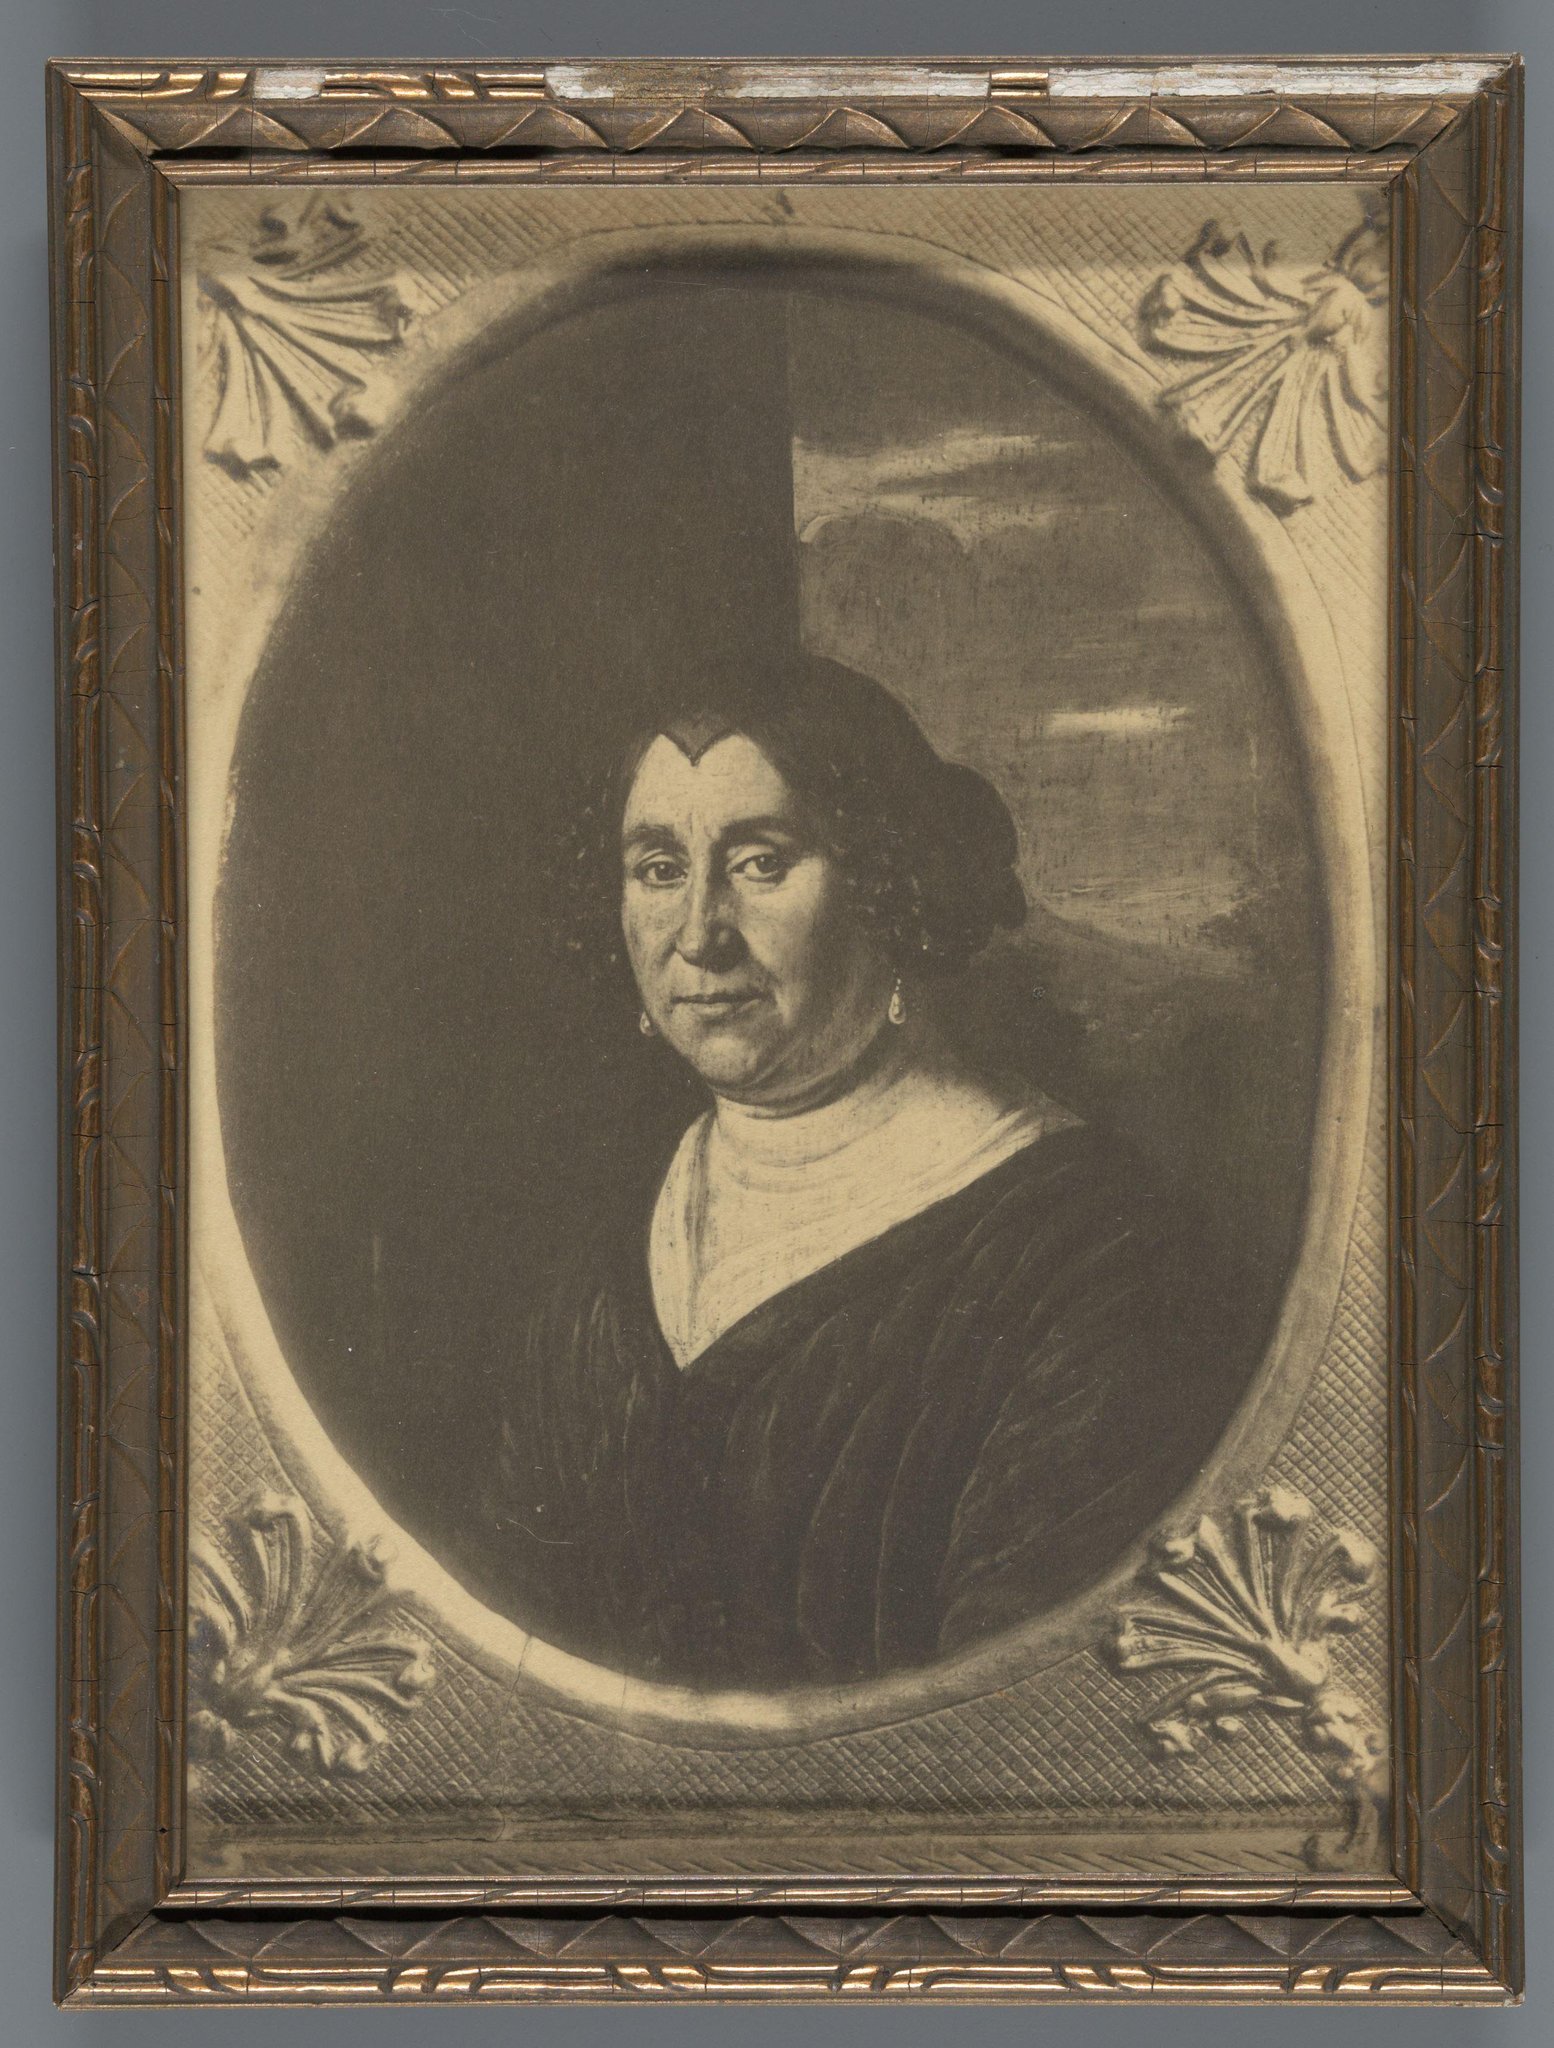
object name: photograph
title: Fotoreproductie van een geschilderd portret van Petronella van Duyren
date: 1890-1930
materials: paper, cardboard, glass, metal, wood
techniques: gelatin silver print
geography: baarn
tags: historical persons - bb - woman, picture, painting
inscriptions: inscription: ‘Petronella van Dueren/ 1644-1712/ vrouw van Dr Gualtherus/ Kolff/ fecit: id. id. id.’, label: ‘Firma/ Erven J.H. Kamp/ Brinkstraat - Baarn/ Spiegel- en -:/ Lijstenhandel’